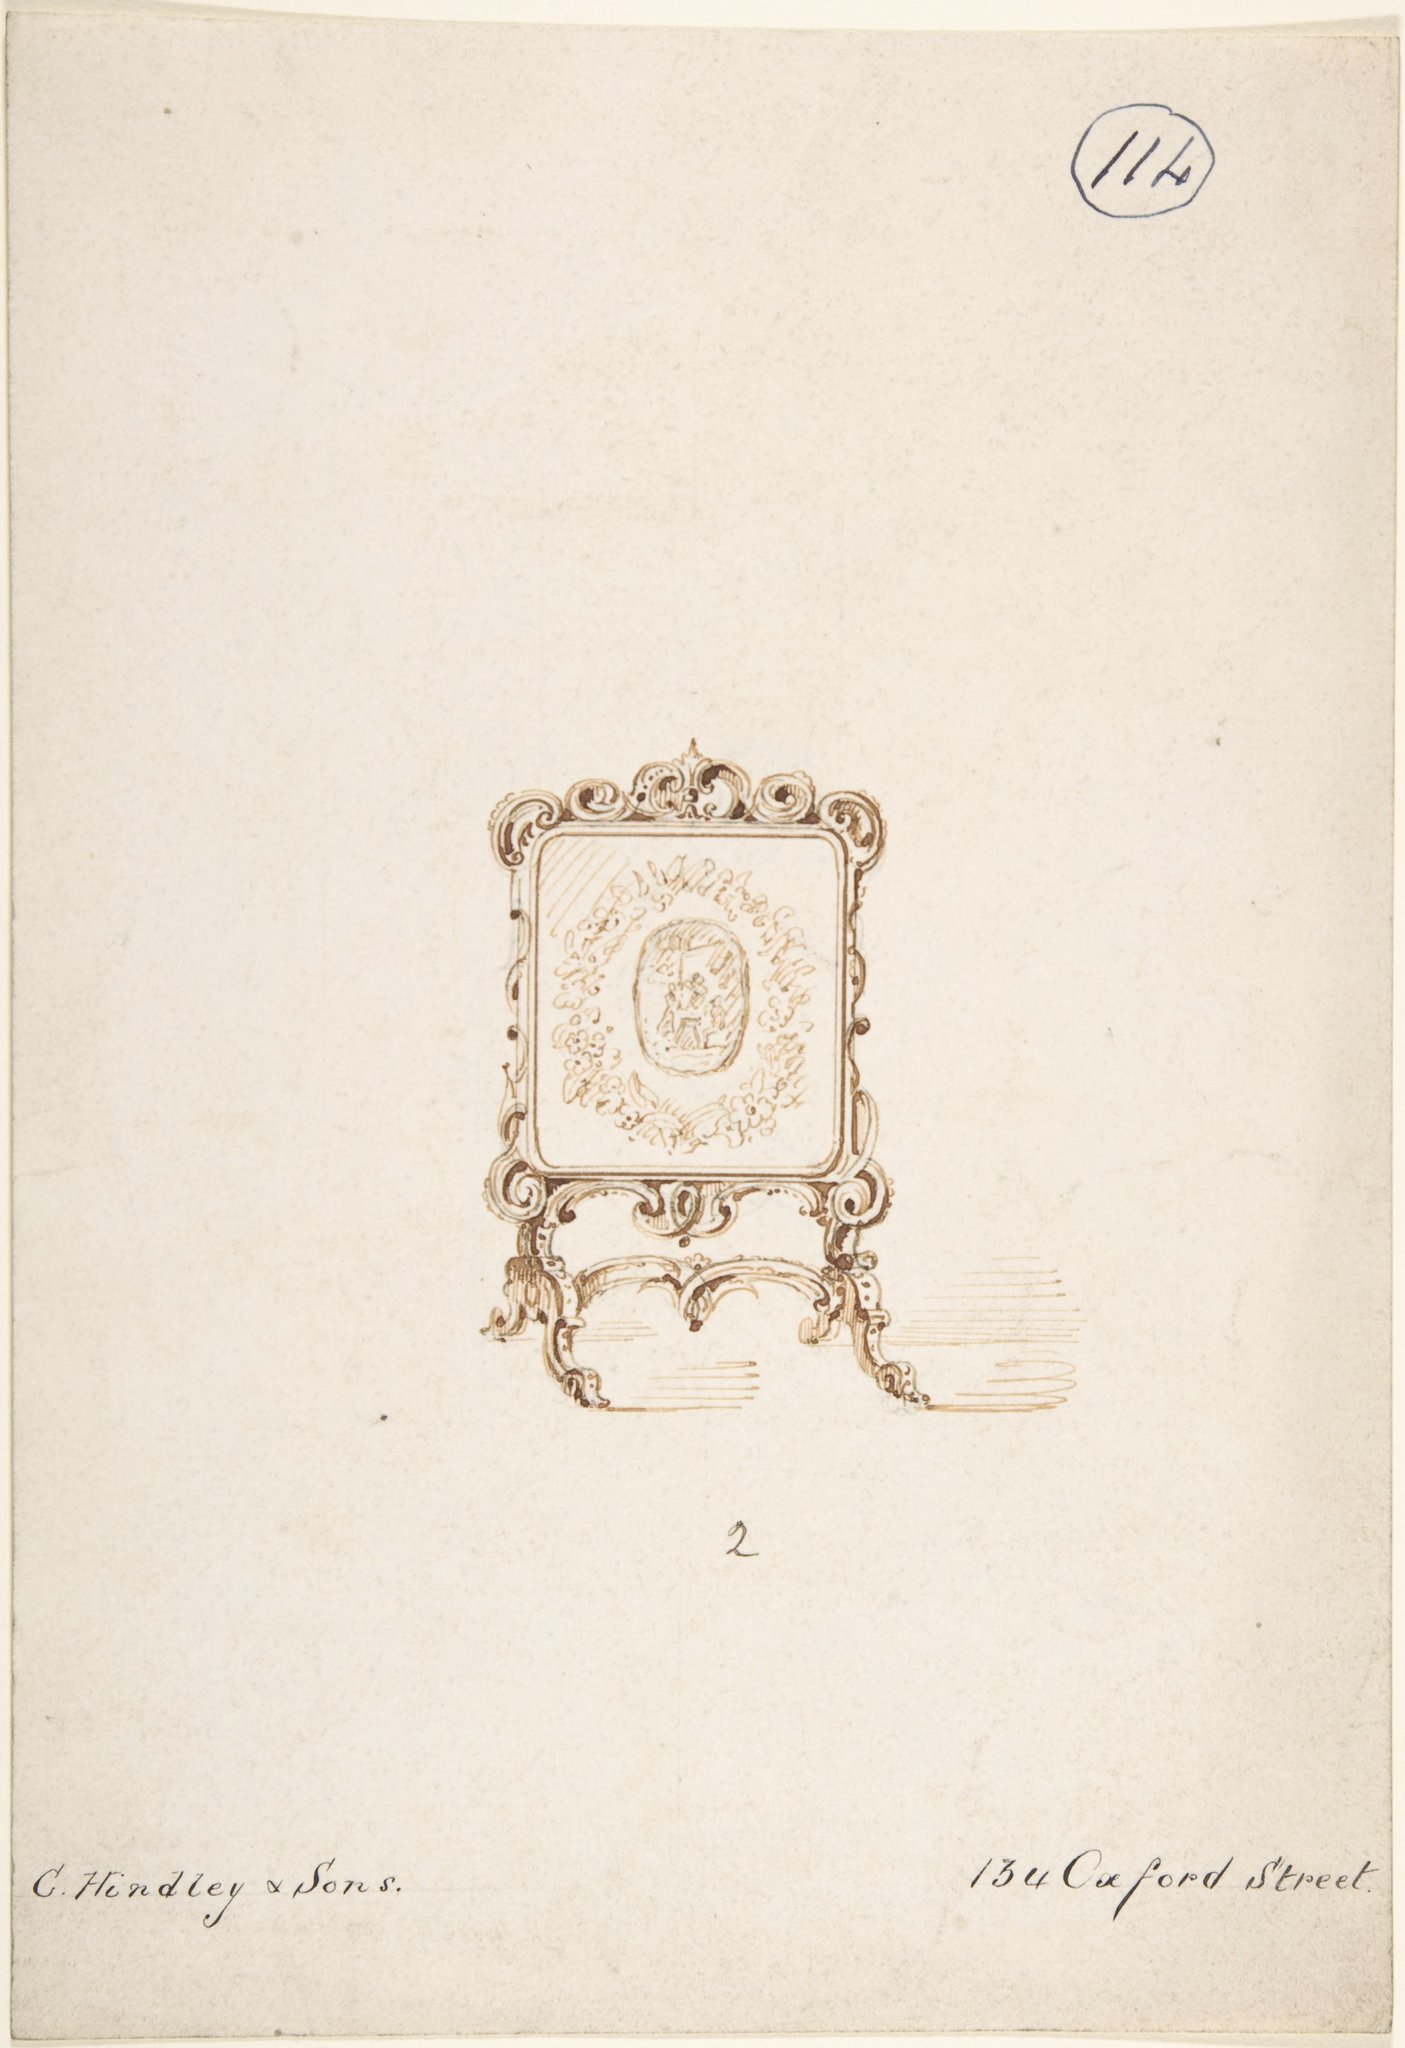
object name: drawing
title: Design for a Screen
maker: charles hindley and sons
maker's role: artist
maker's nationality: british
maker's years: 1841-1917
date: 1841-1884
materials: graphite, ink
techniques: pen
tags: screens